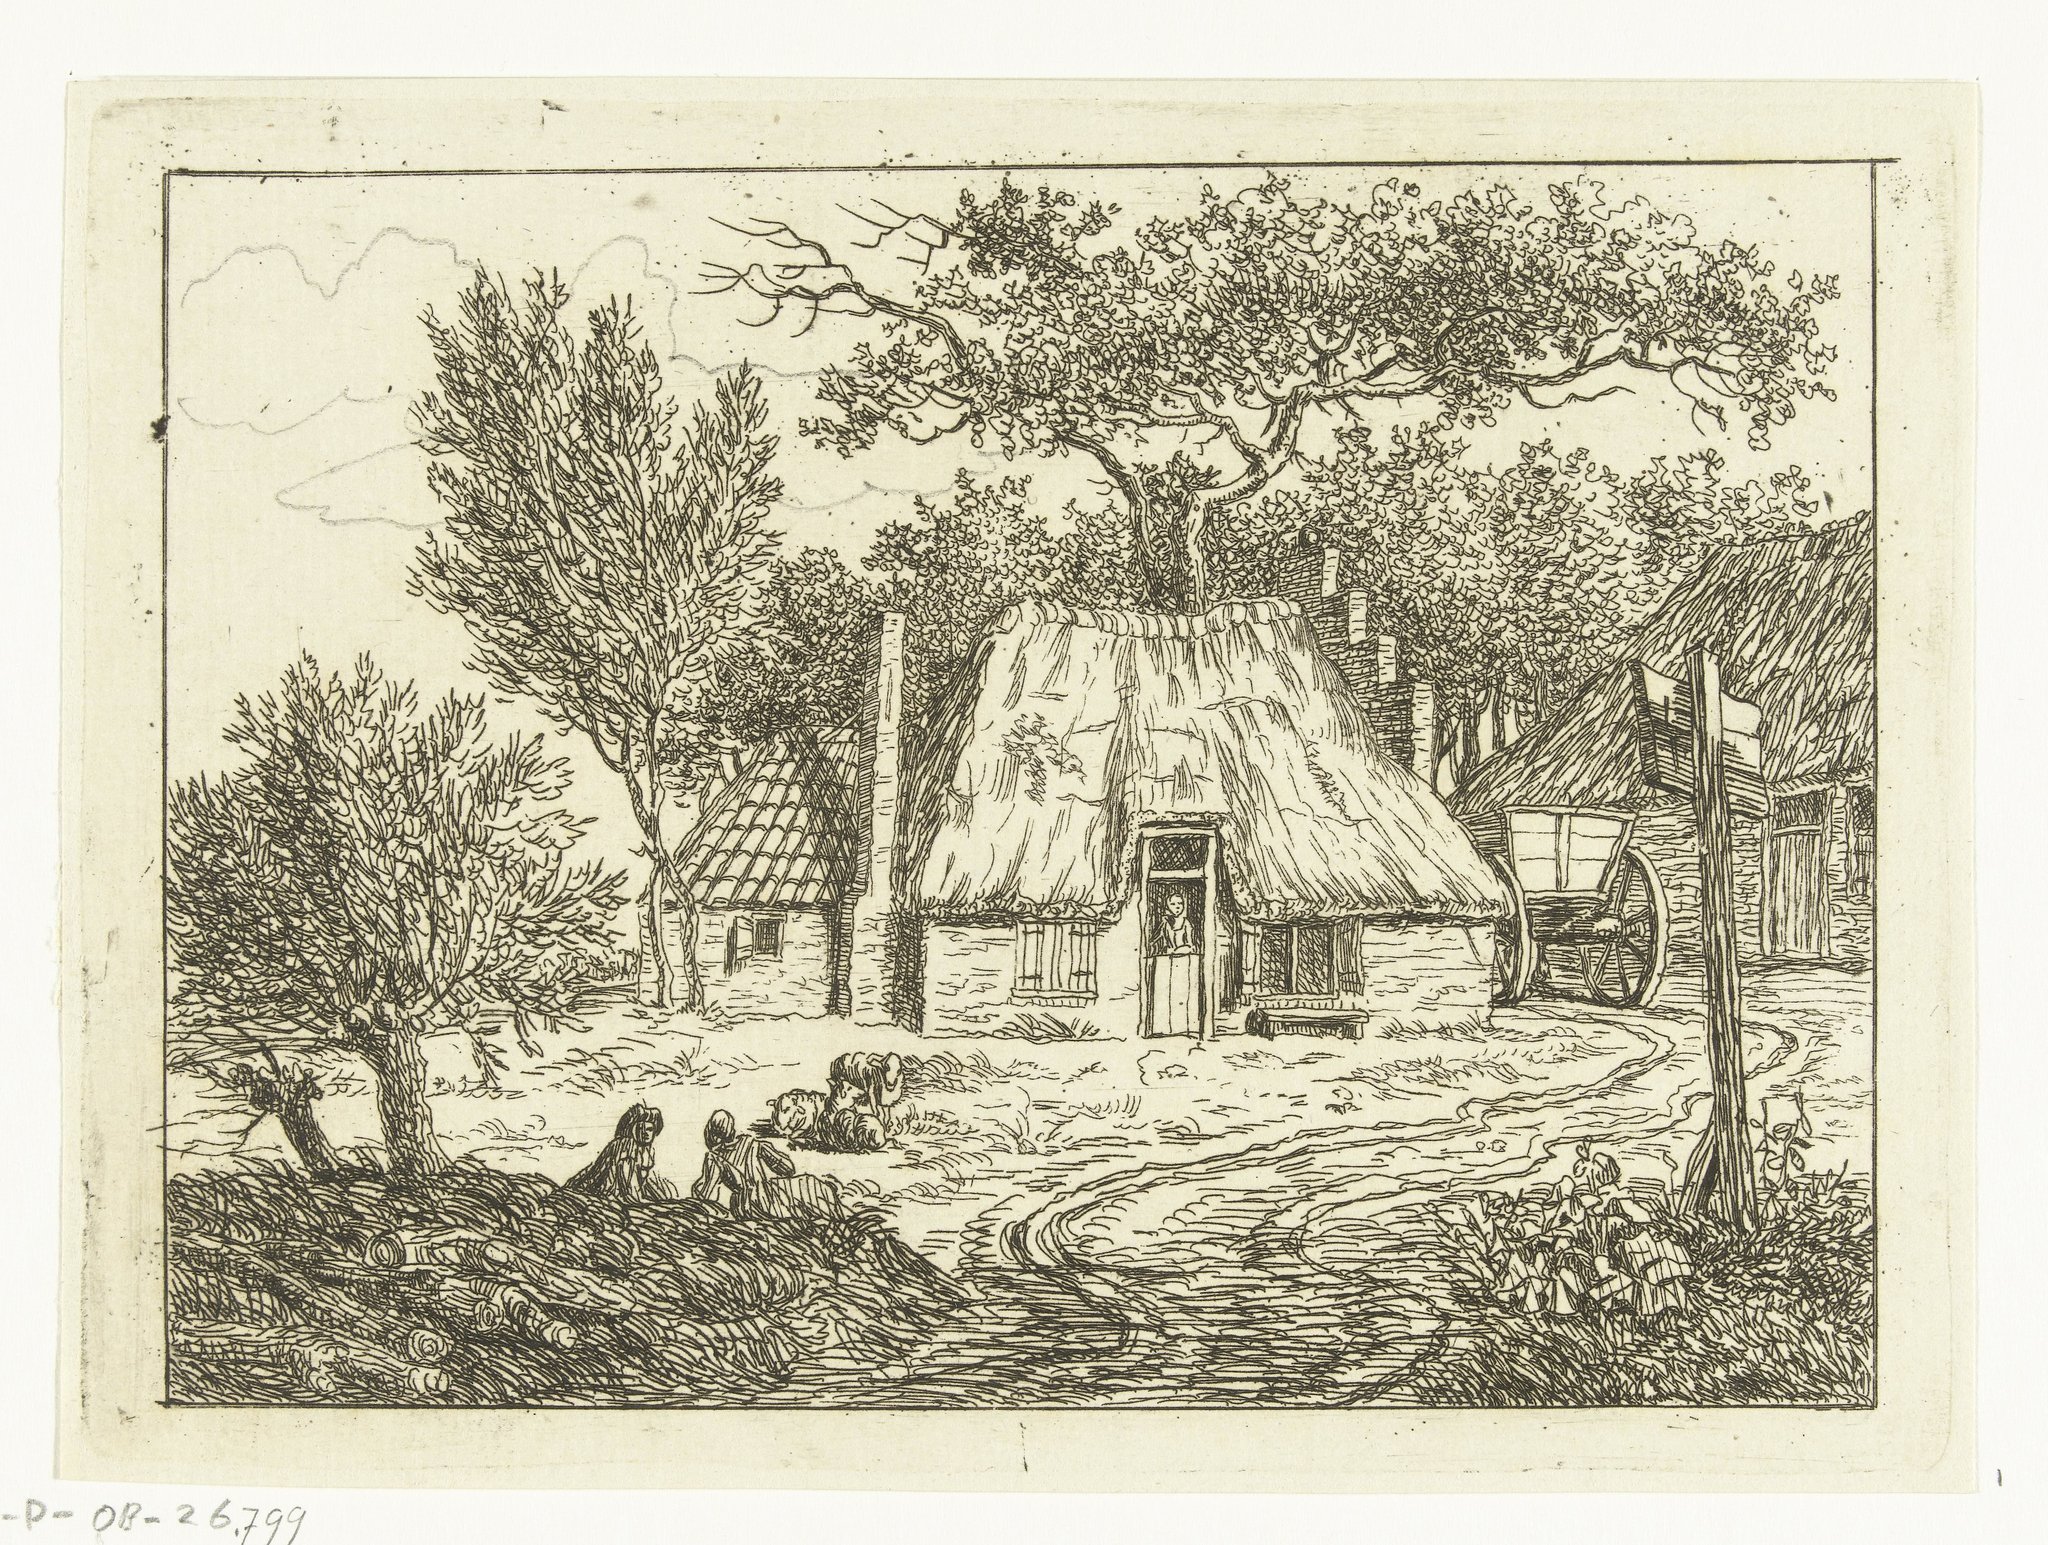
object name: print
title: Kar staande naast boerderij met trapgevel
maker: anthonie van den bos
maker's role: draughtsman, print maker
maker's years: 1763-1838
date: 1778-1838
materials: paper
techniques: etching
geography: netherlands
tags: farm or solitary house in landscape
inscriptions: collector's mark: Lugt 2228